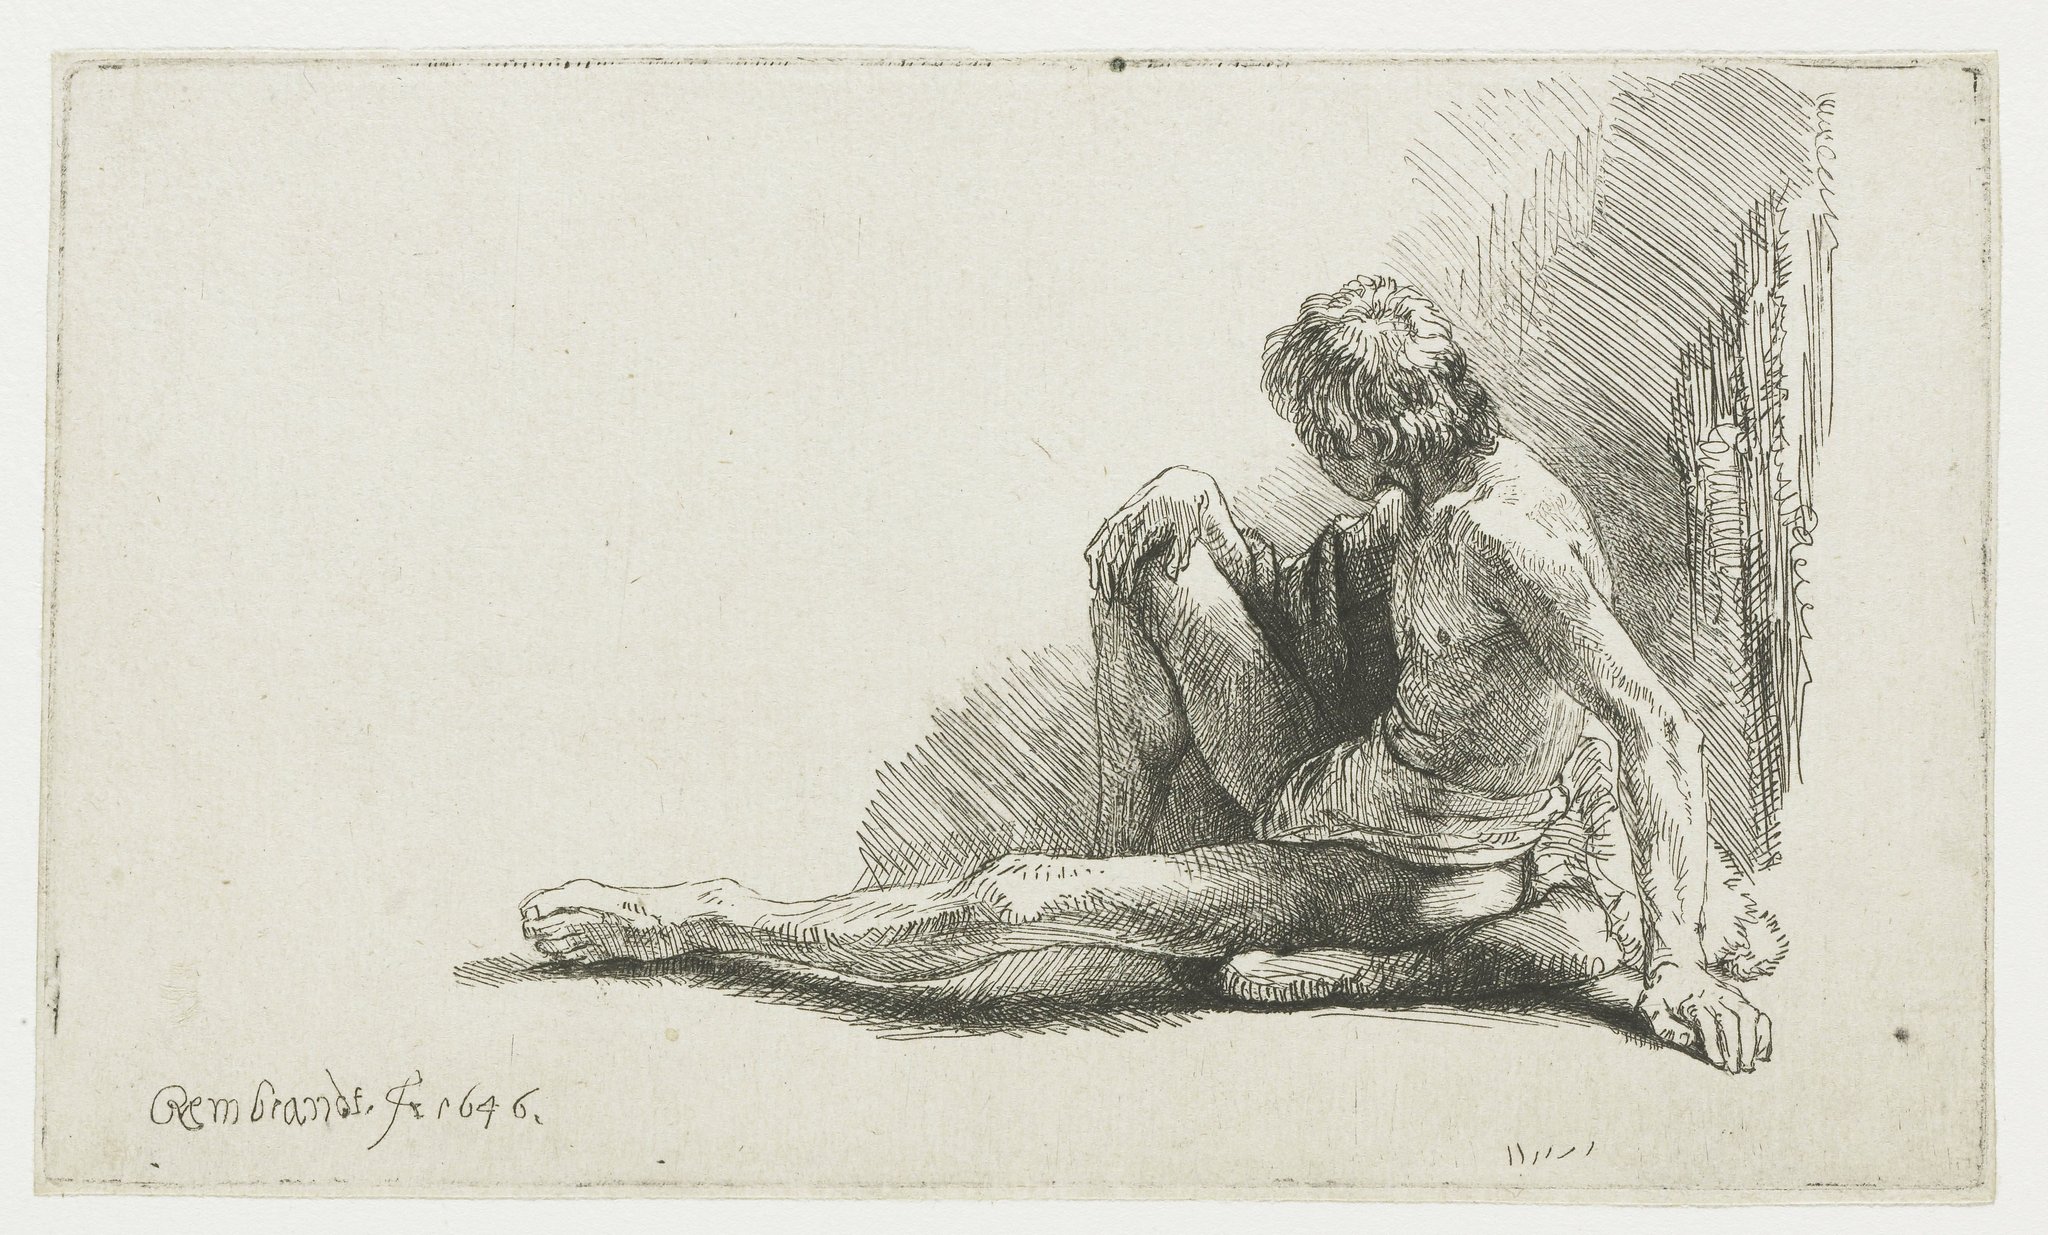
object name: print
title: Nude man seated on the ground with one leg extended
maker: rembrandt van rijn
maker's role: draughtsman, painter, print maker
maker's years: 1606-1669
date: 1646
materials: paper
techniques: etching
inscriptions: collector's mark: Lugt 240, signature and date: ‘Rembrandt ft 1646’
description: This study originated during one of Rembrandt’s lessons for his pupils. Rembrandt sketched the model from life directly on the copperplate, while his students also drew him on paper, each from a different angle. Afterwards, Rembrandt worked the plate anew, intensifying the shadows with the aid of a burin.